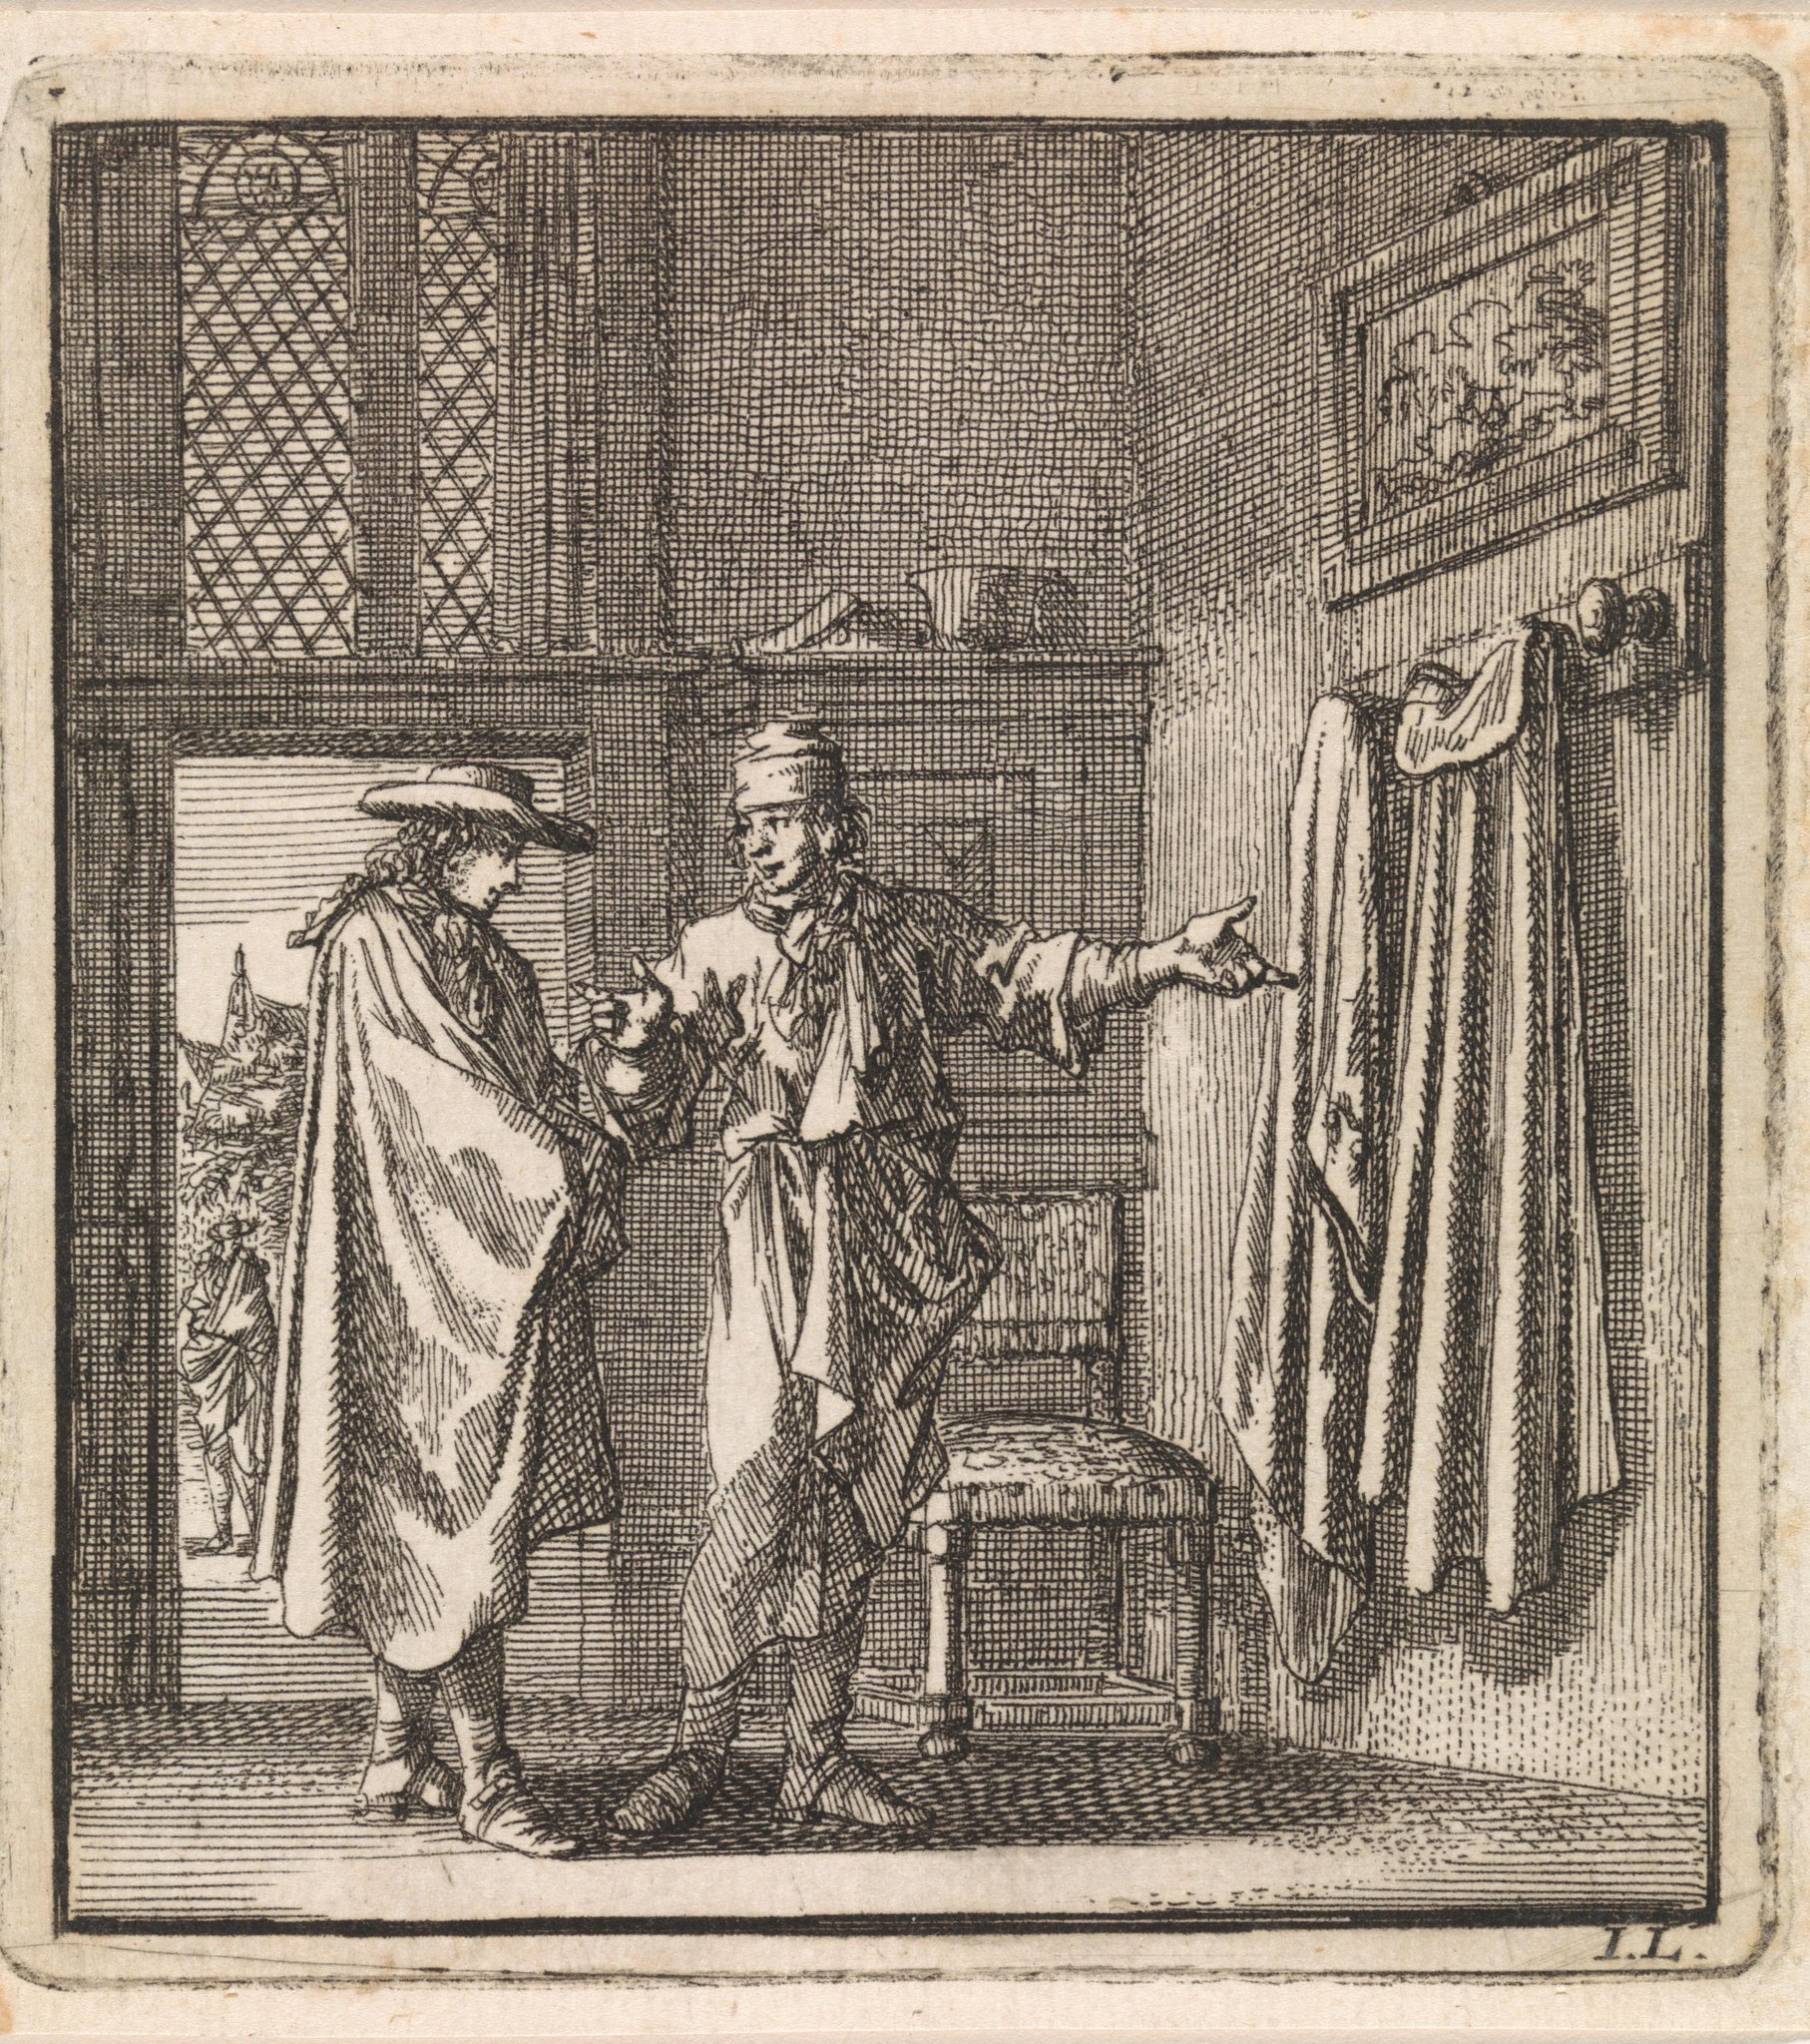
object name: print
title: De Kapstok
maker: jan luyken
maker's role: draughtsman, print maker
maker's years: 1649-1712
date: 1711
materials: paper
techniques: etching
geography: amsterdam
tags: cape (+ men's clothes)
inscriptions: collector's mark: Lugt 2228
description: Illustratie voor: Luyken, Jan. Het leerzaam huisraad, vertoond in vyftig konstige figuuren, met godlyke spreuken en stichtelyke verzen: Pieter Arentsz. II (wed.) en Cornelis van der Sys, 1711, p. 60.